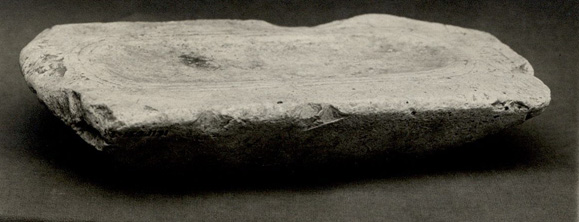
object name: palette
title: Painting Palette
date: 1981-1640 BCE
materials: limestone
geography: egypt